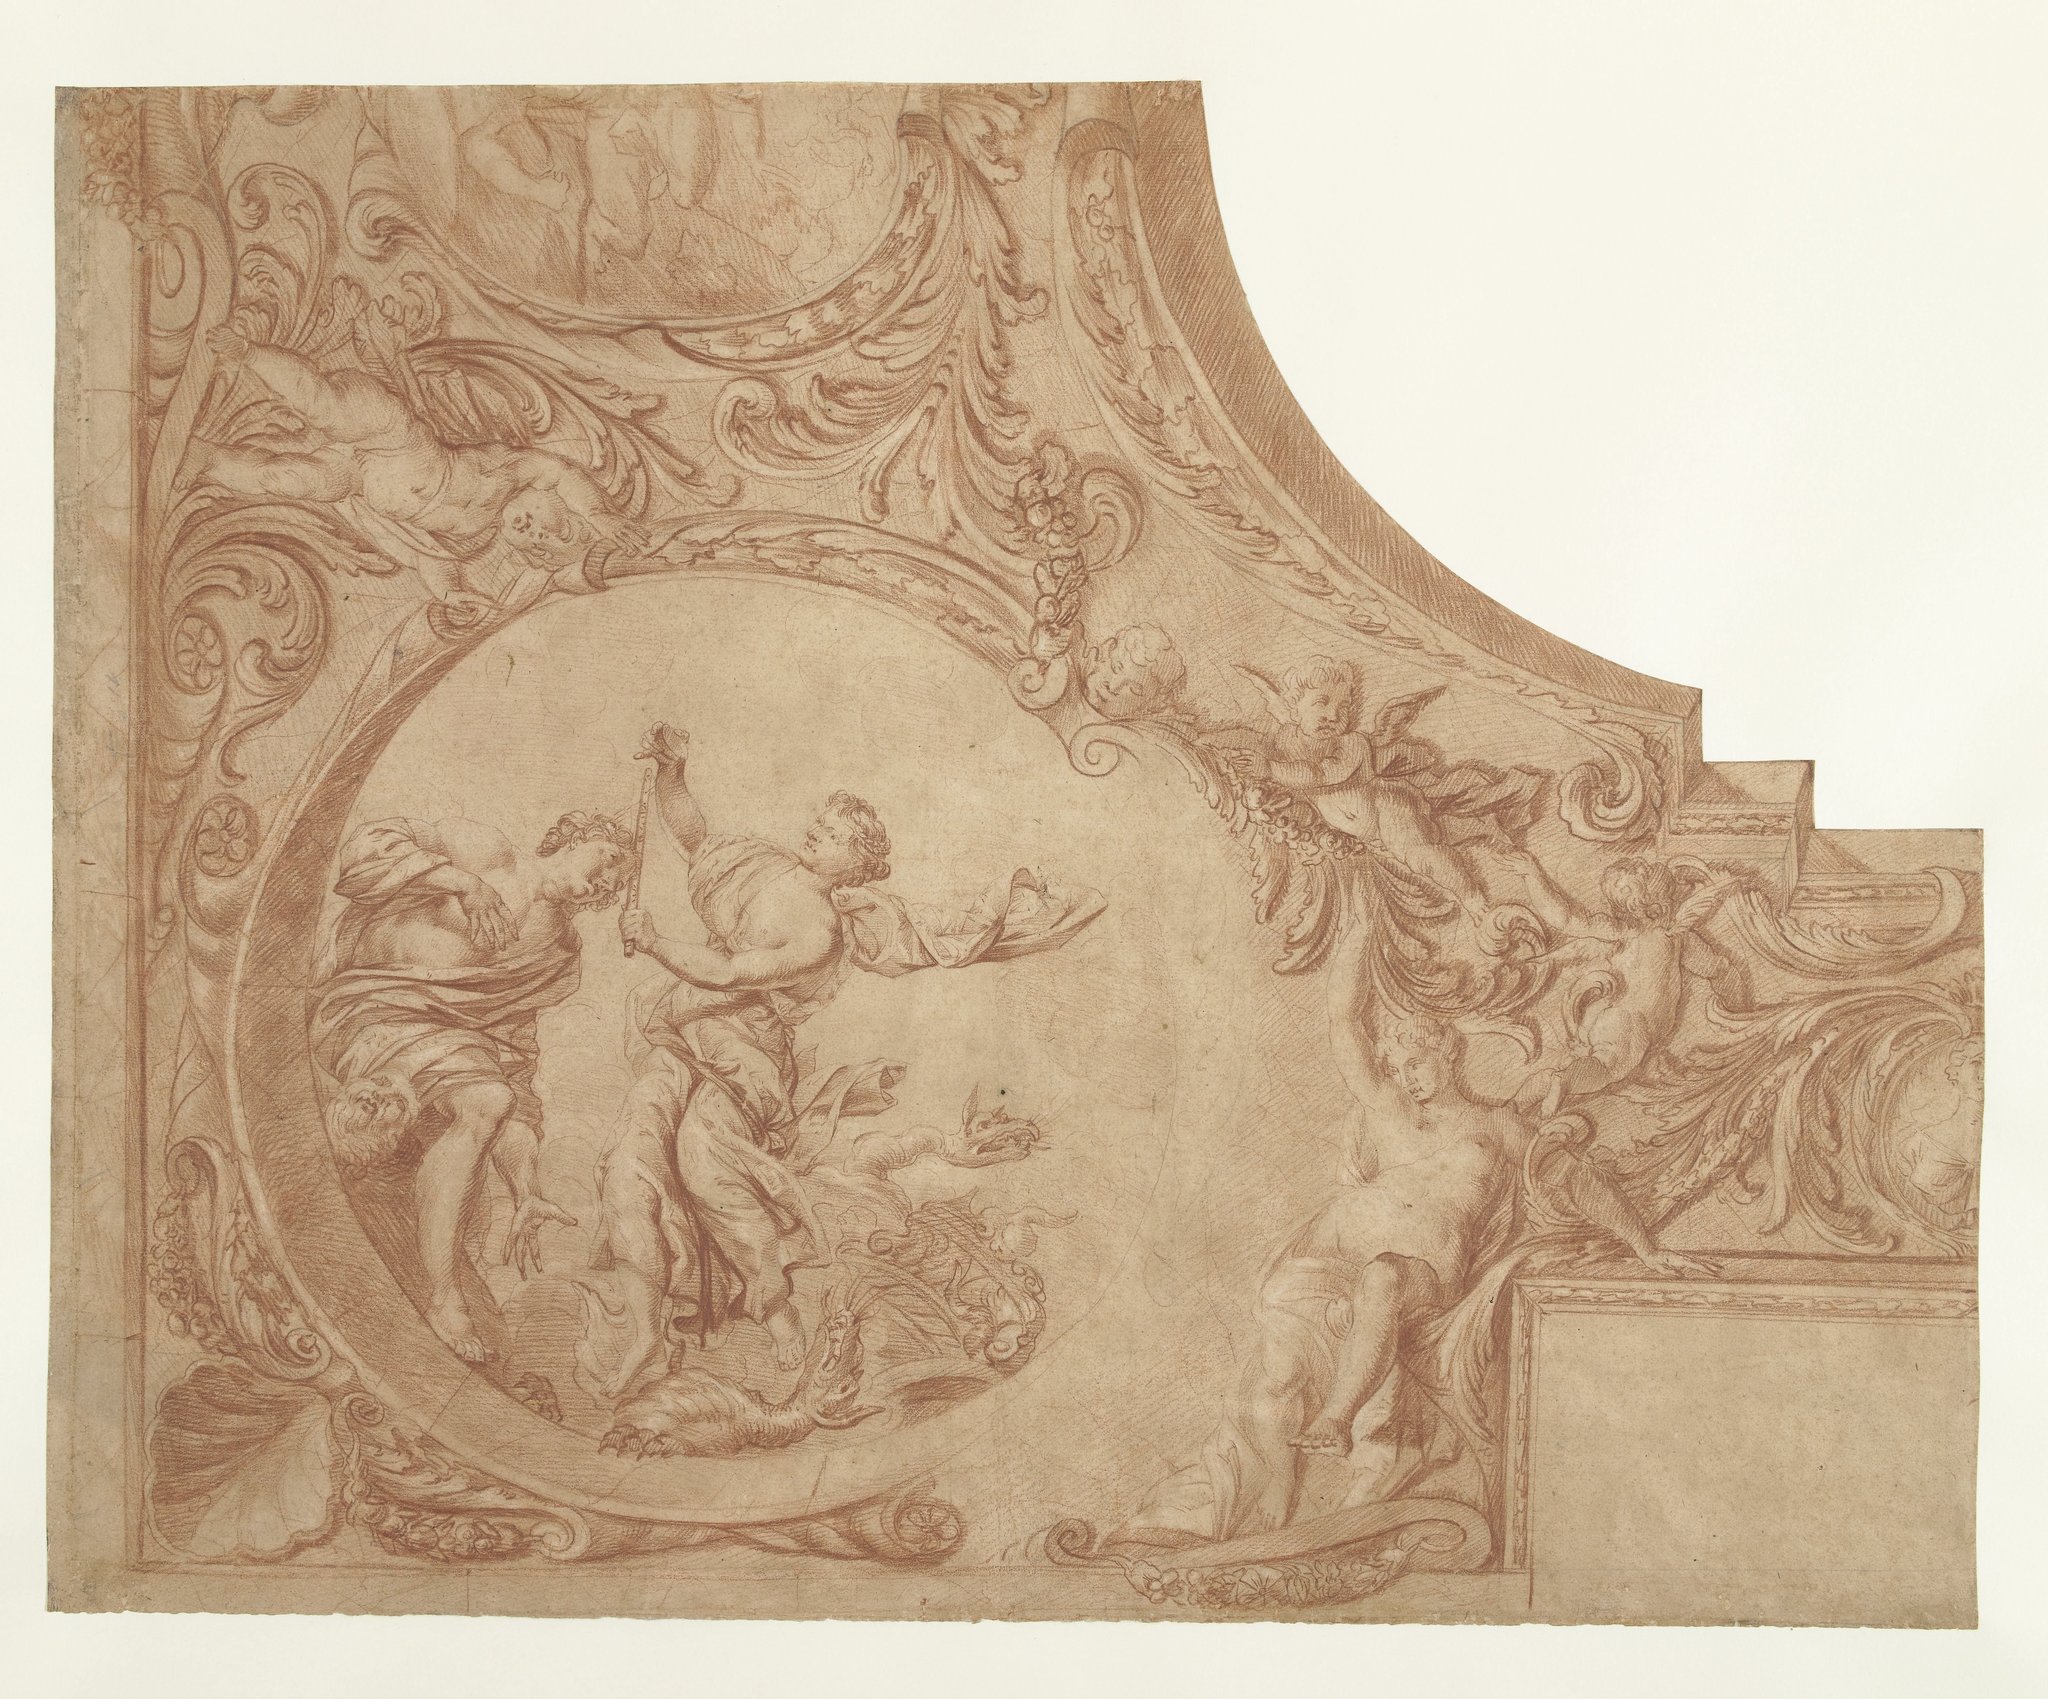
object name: drawing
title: Ontwerp voor een hoekstuk van een plafond met Jason en Medea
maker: mattheus terwesten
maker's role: draughtsman, painter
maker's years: 1670-1757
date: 1680-1757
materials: chalk, paper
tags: acanthus ~ ornament, venus mourning adonis, (decorated) ceiling, jason and medea at the altar of hecate (or diana): medea gives him a magic herb or ointment, cupids: 'amores', 'amoretti', 'putti'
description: Hoekstuk van een plafond met Jason en Medea in een ronde cartouche; links de helft van een voorstelling van Venus treurend bij het lichaam van Adonis.